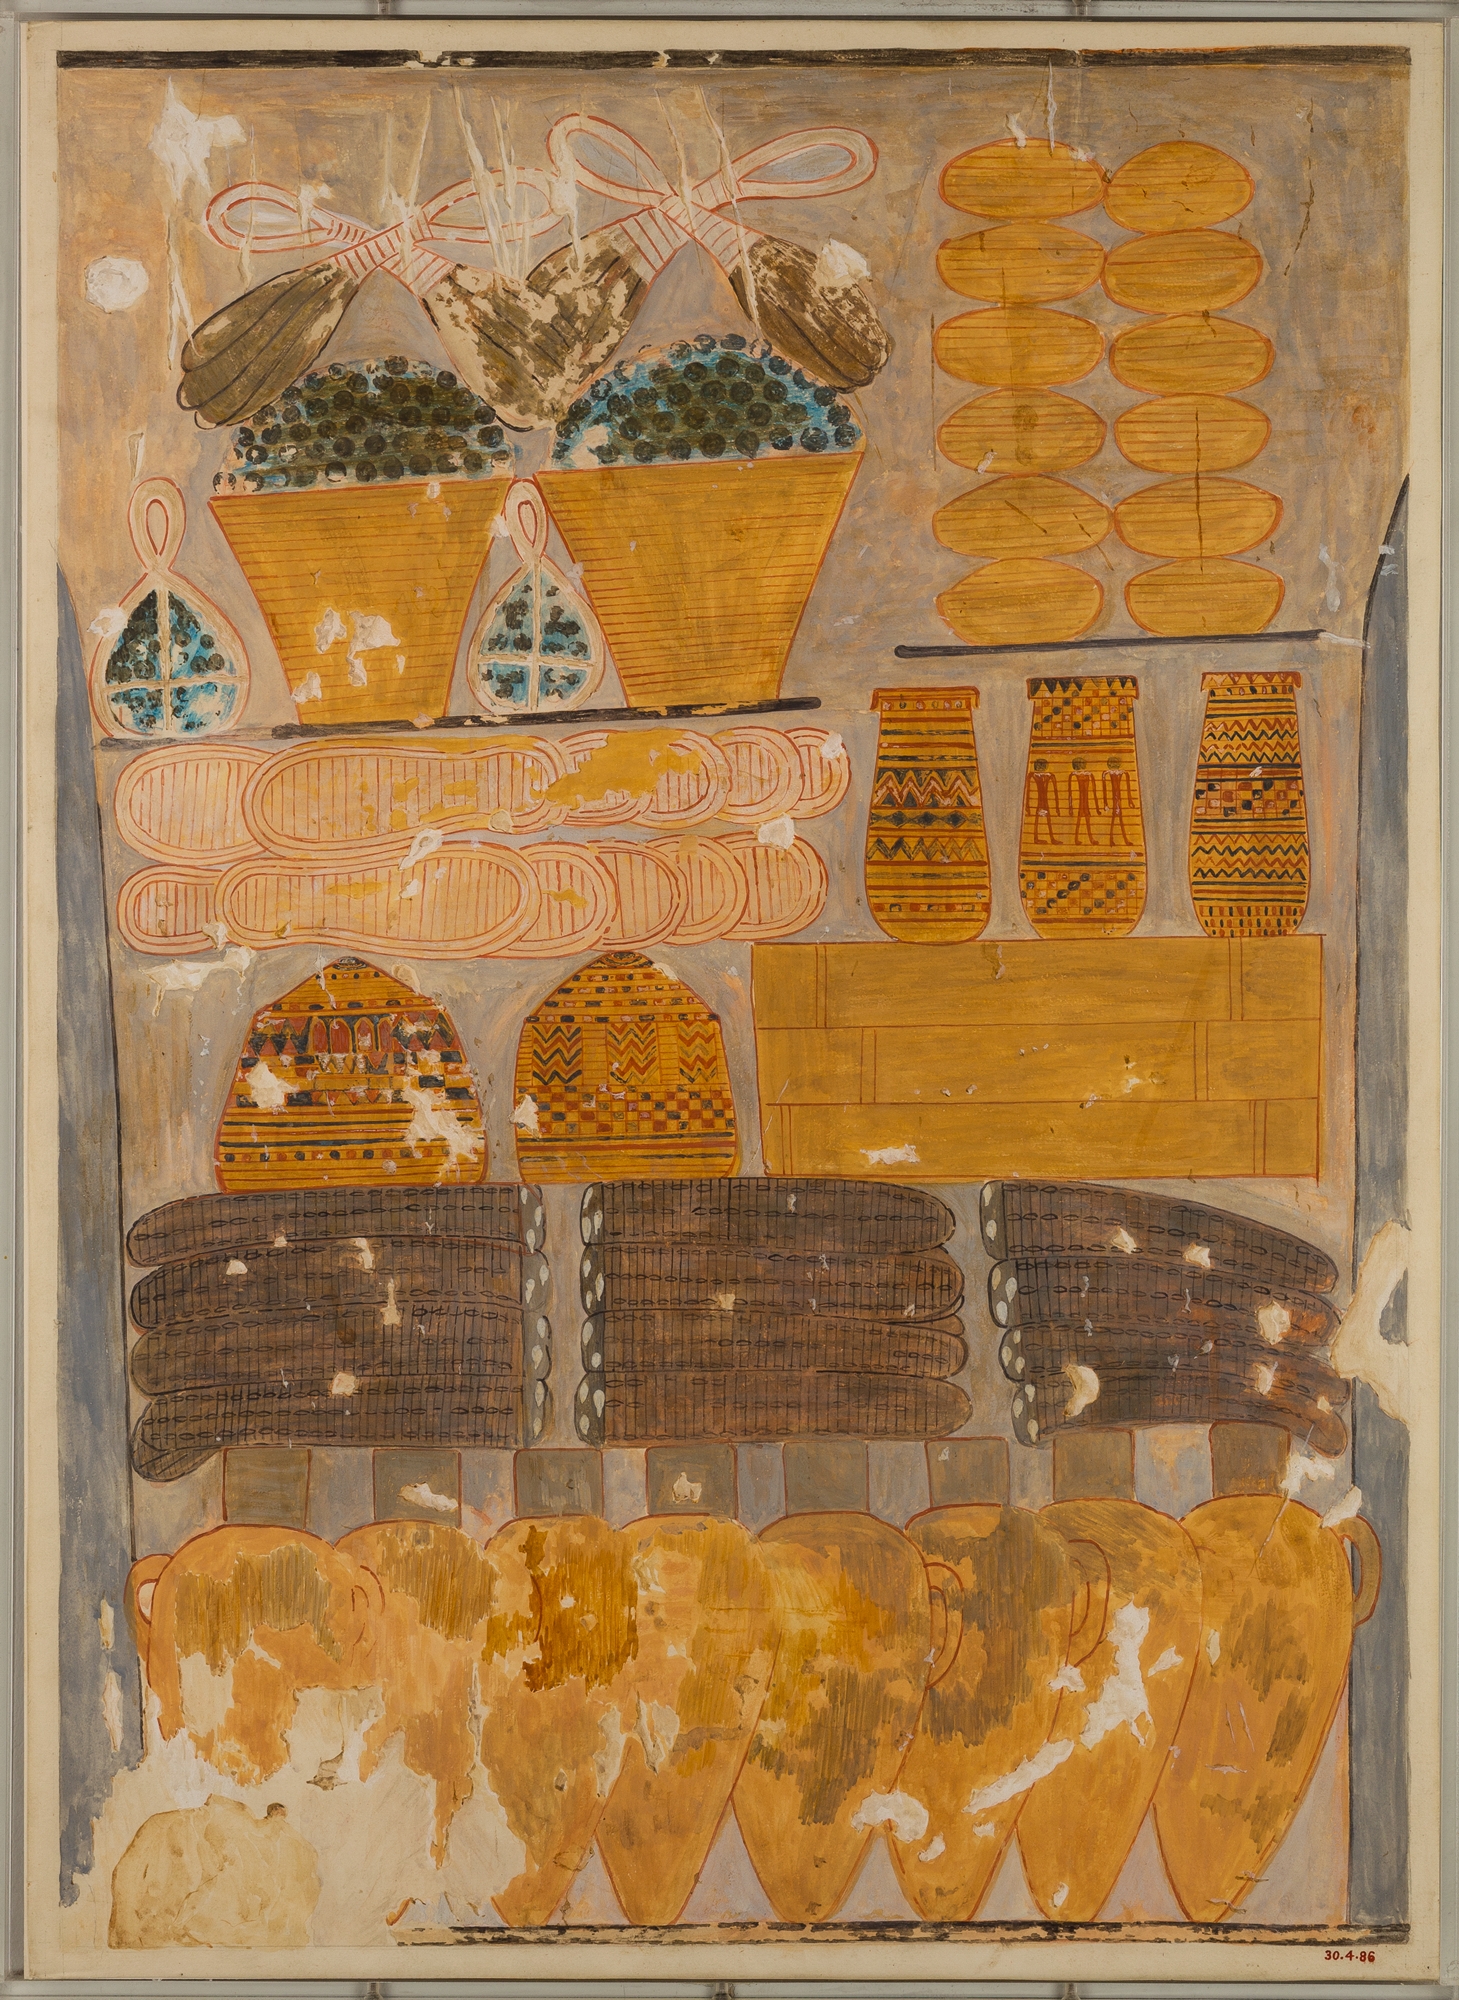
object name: facsimile, rekhmire tt 100, provision magazine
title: Provisions Stored in the Temple, Tomb of Rekhmire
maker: nina de garis davies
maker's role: artist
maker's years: 1881-1965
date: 1479-1425 BCE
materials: paper, paint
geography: egypt